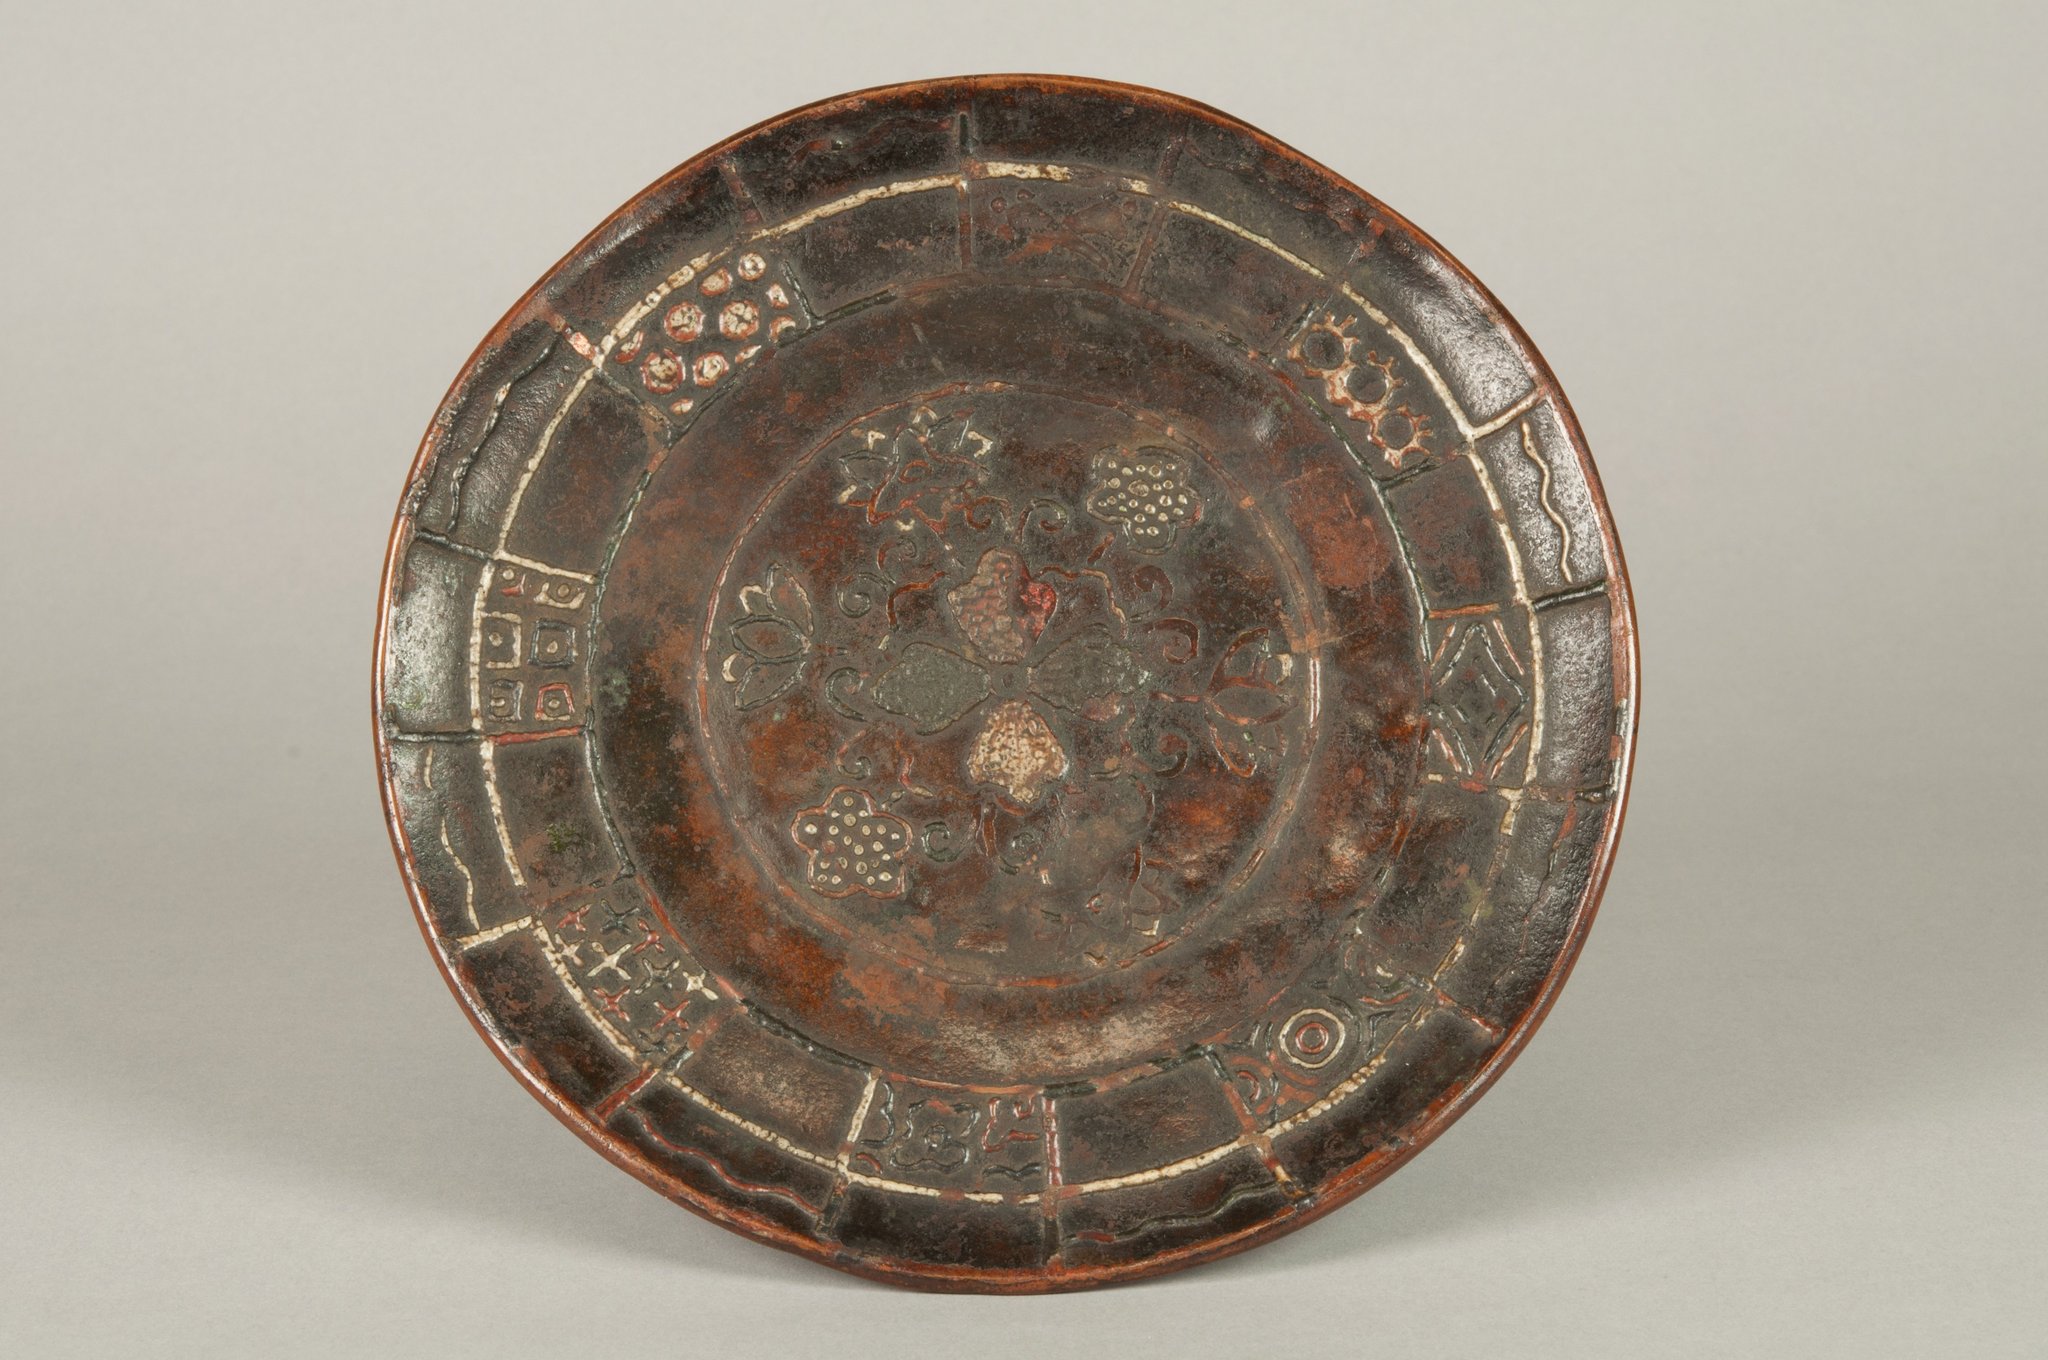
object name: plate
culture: japanese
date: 1801-1900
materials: iron, lacquer